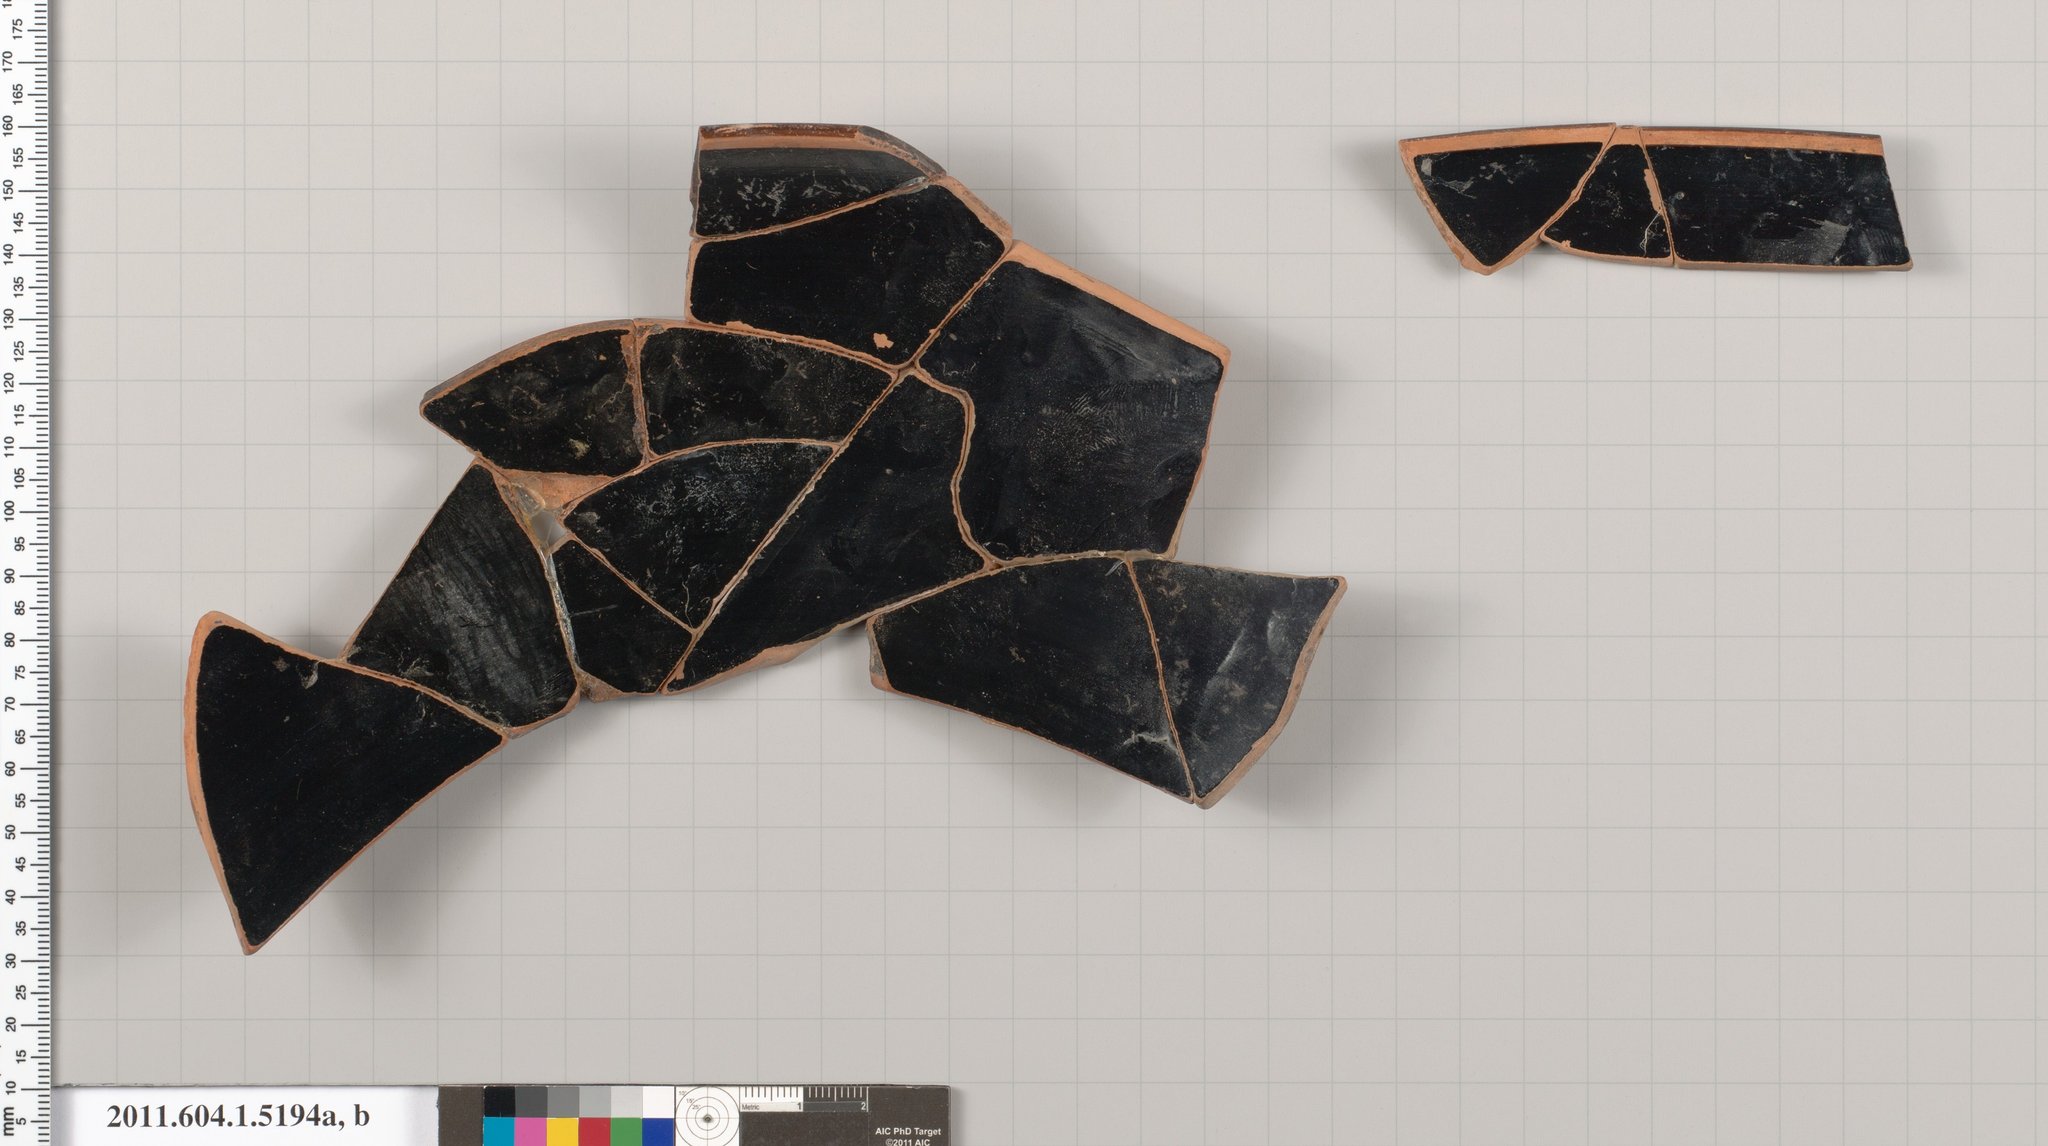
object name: kylix fragment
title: Terracotta fragments of a kylix (drinking cup)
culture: greek, attic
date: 520-510 BCE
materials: terracotta